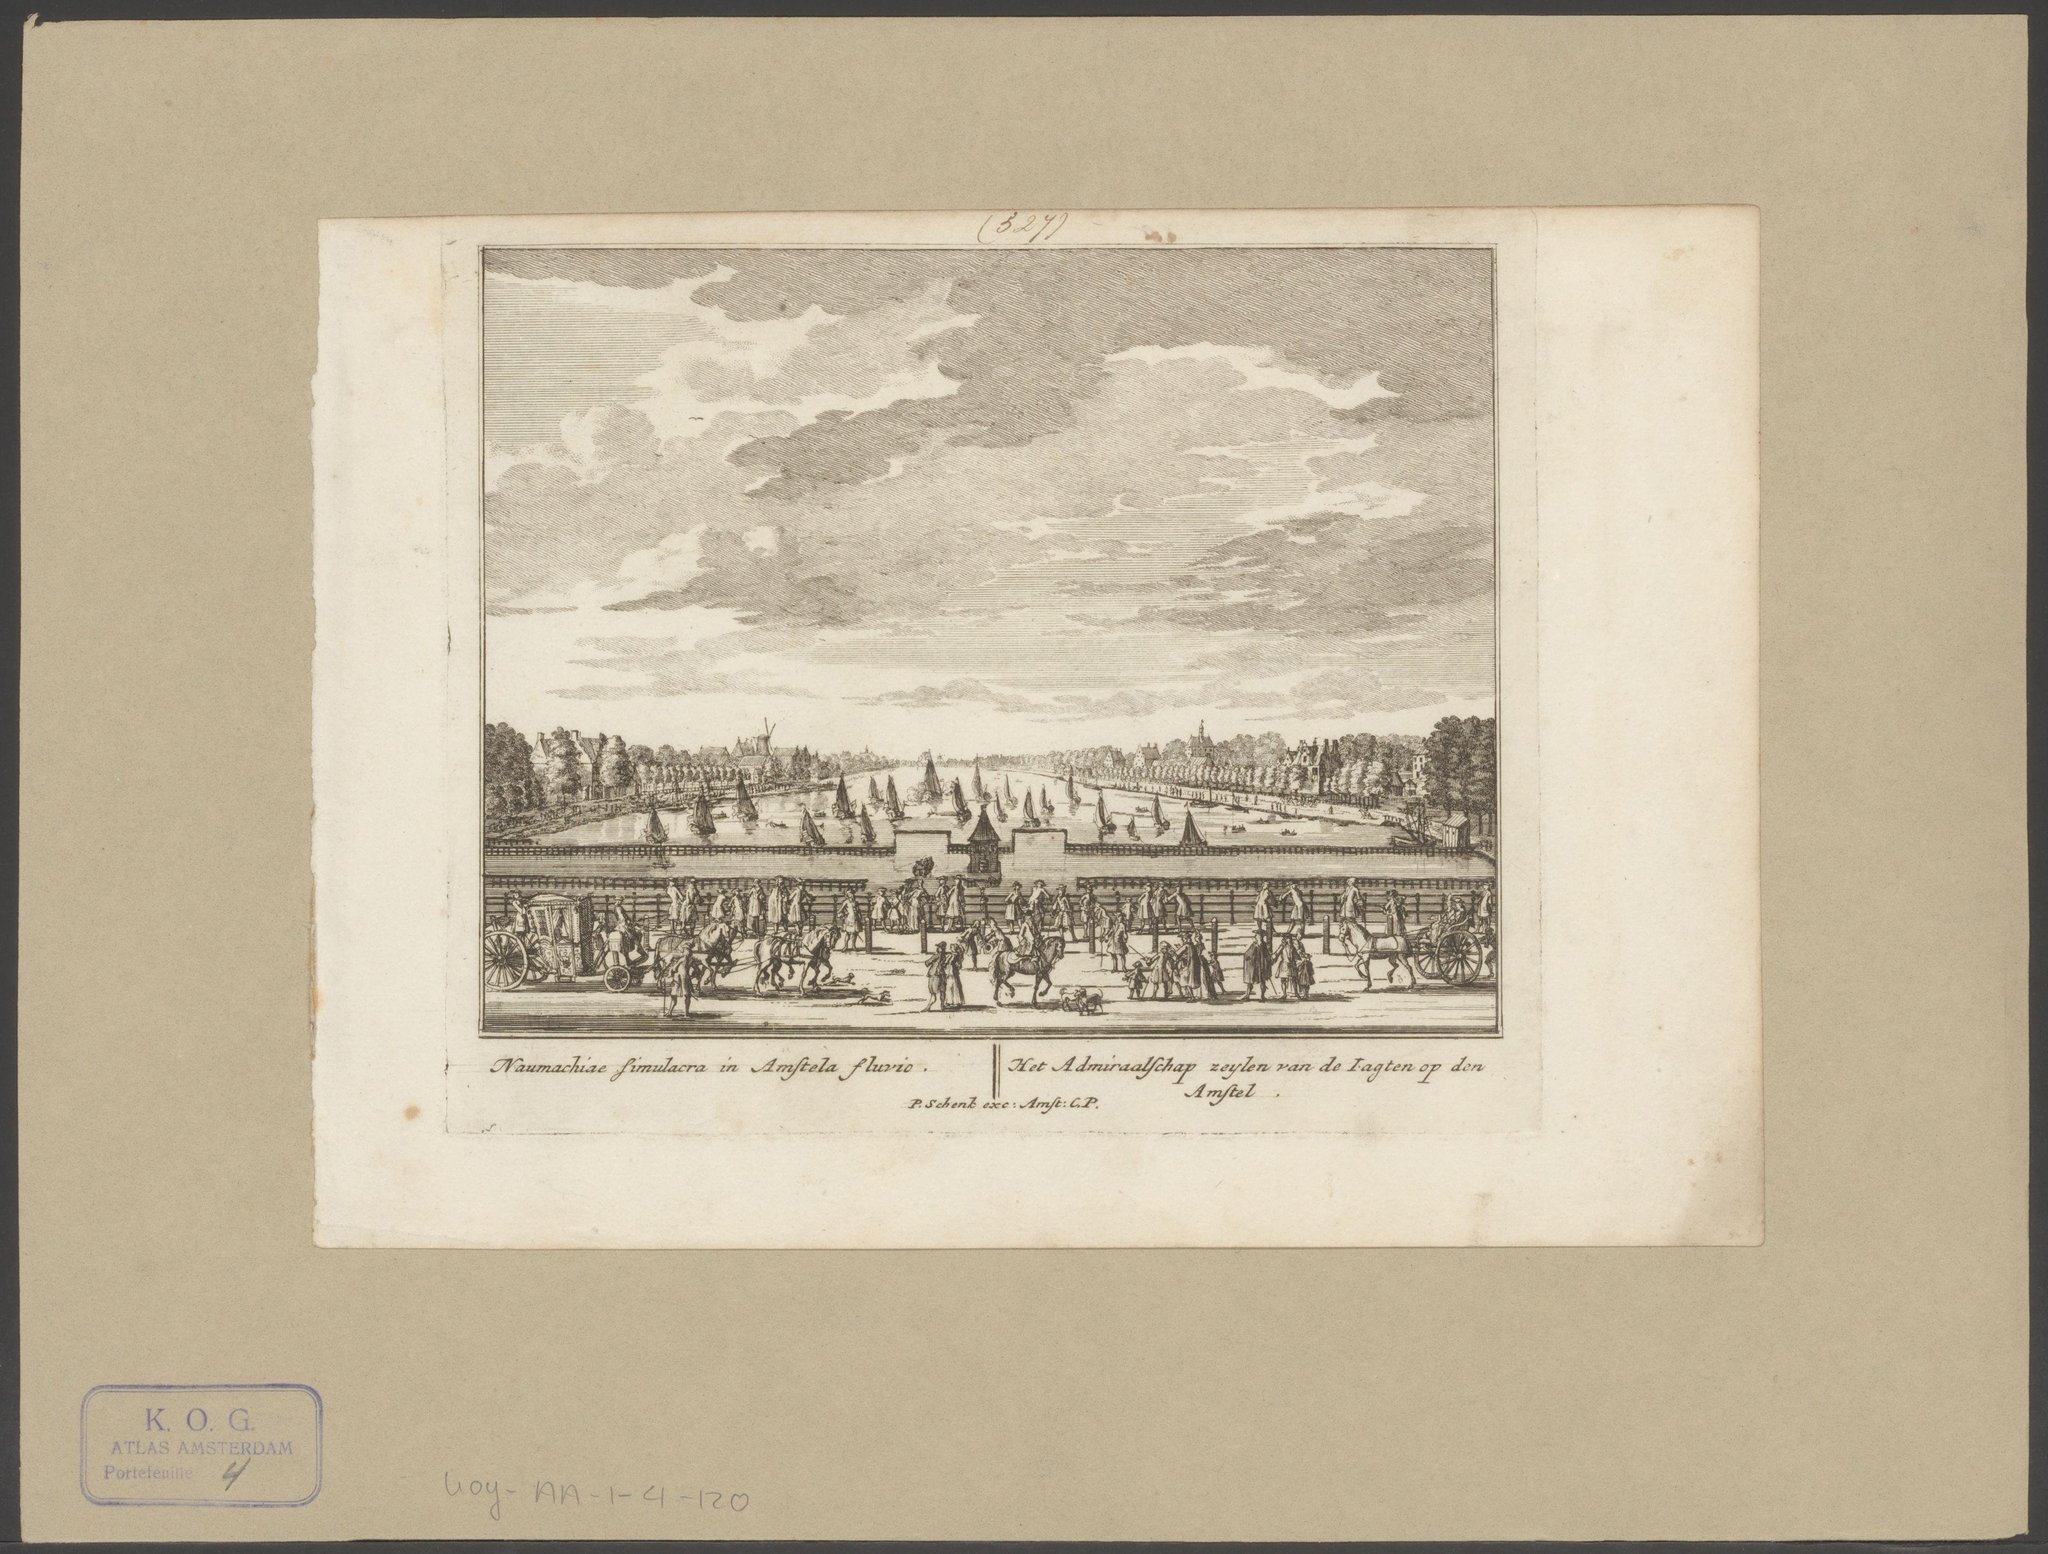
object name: print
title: Admirandorum Quadruplex Spectaculum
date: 1694-1697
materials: paper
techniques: etching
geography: amsterdam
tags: city-view in general; 'veduta', river, ships (in general) - cc - more than one ship, bridge in city across river, canal, etc.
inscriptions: collector's mark: ‘4’ Lugt 1641b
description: Prent gebruikt in: Call, Jan van. Admirandorum Quadruplex Spectaculum. Amsterdam: Pieter Schenk (I), 1700. De titelprent, opdracht en het portret van Frederik van Saksen zijn gegraveerd door Pieter Schenk (I). De overige prenten uit deze serie zijn, zoals aangegeven op de titelprent, van de hand van Jan van Call (I).